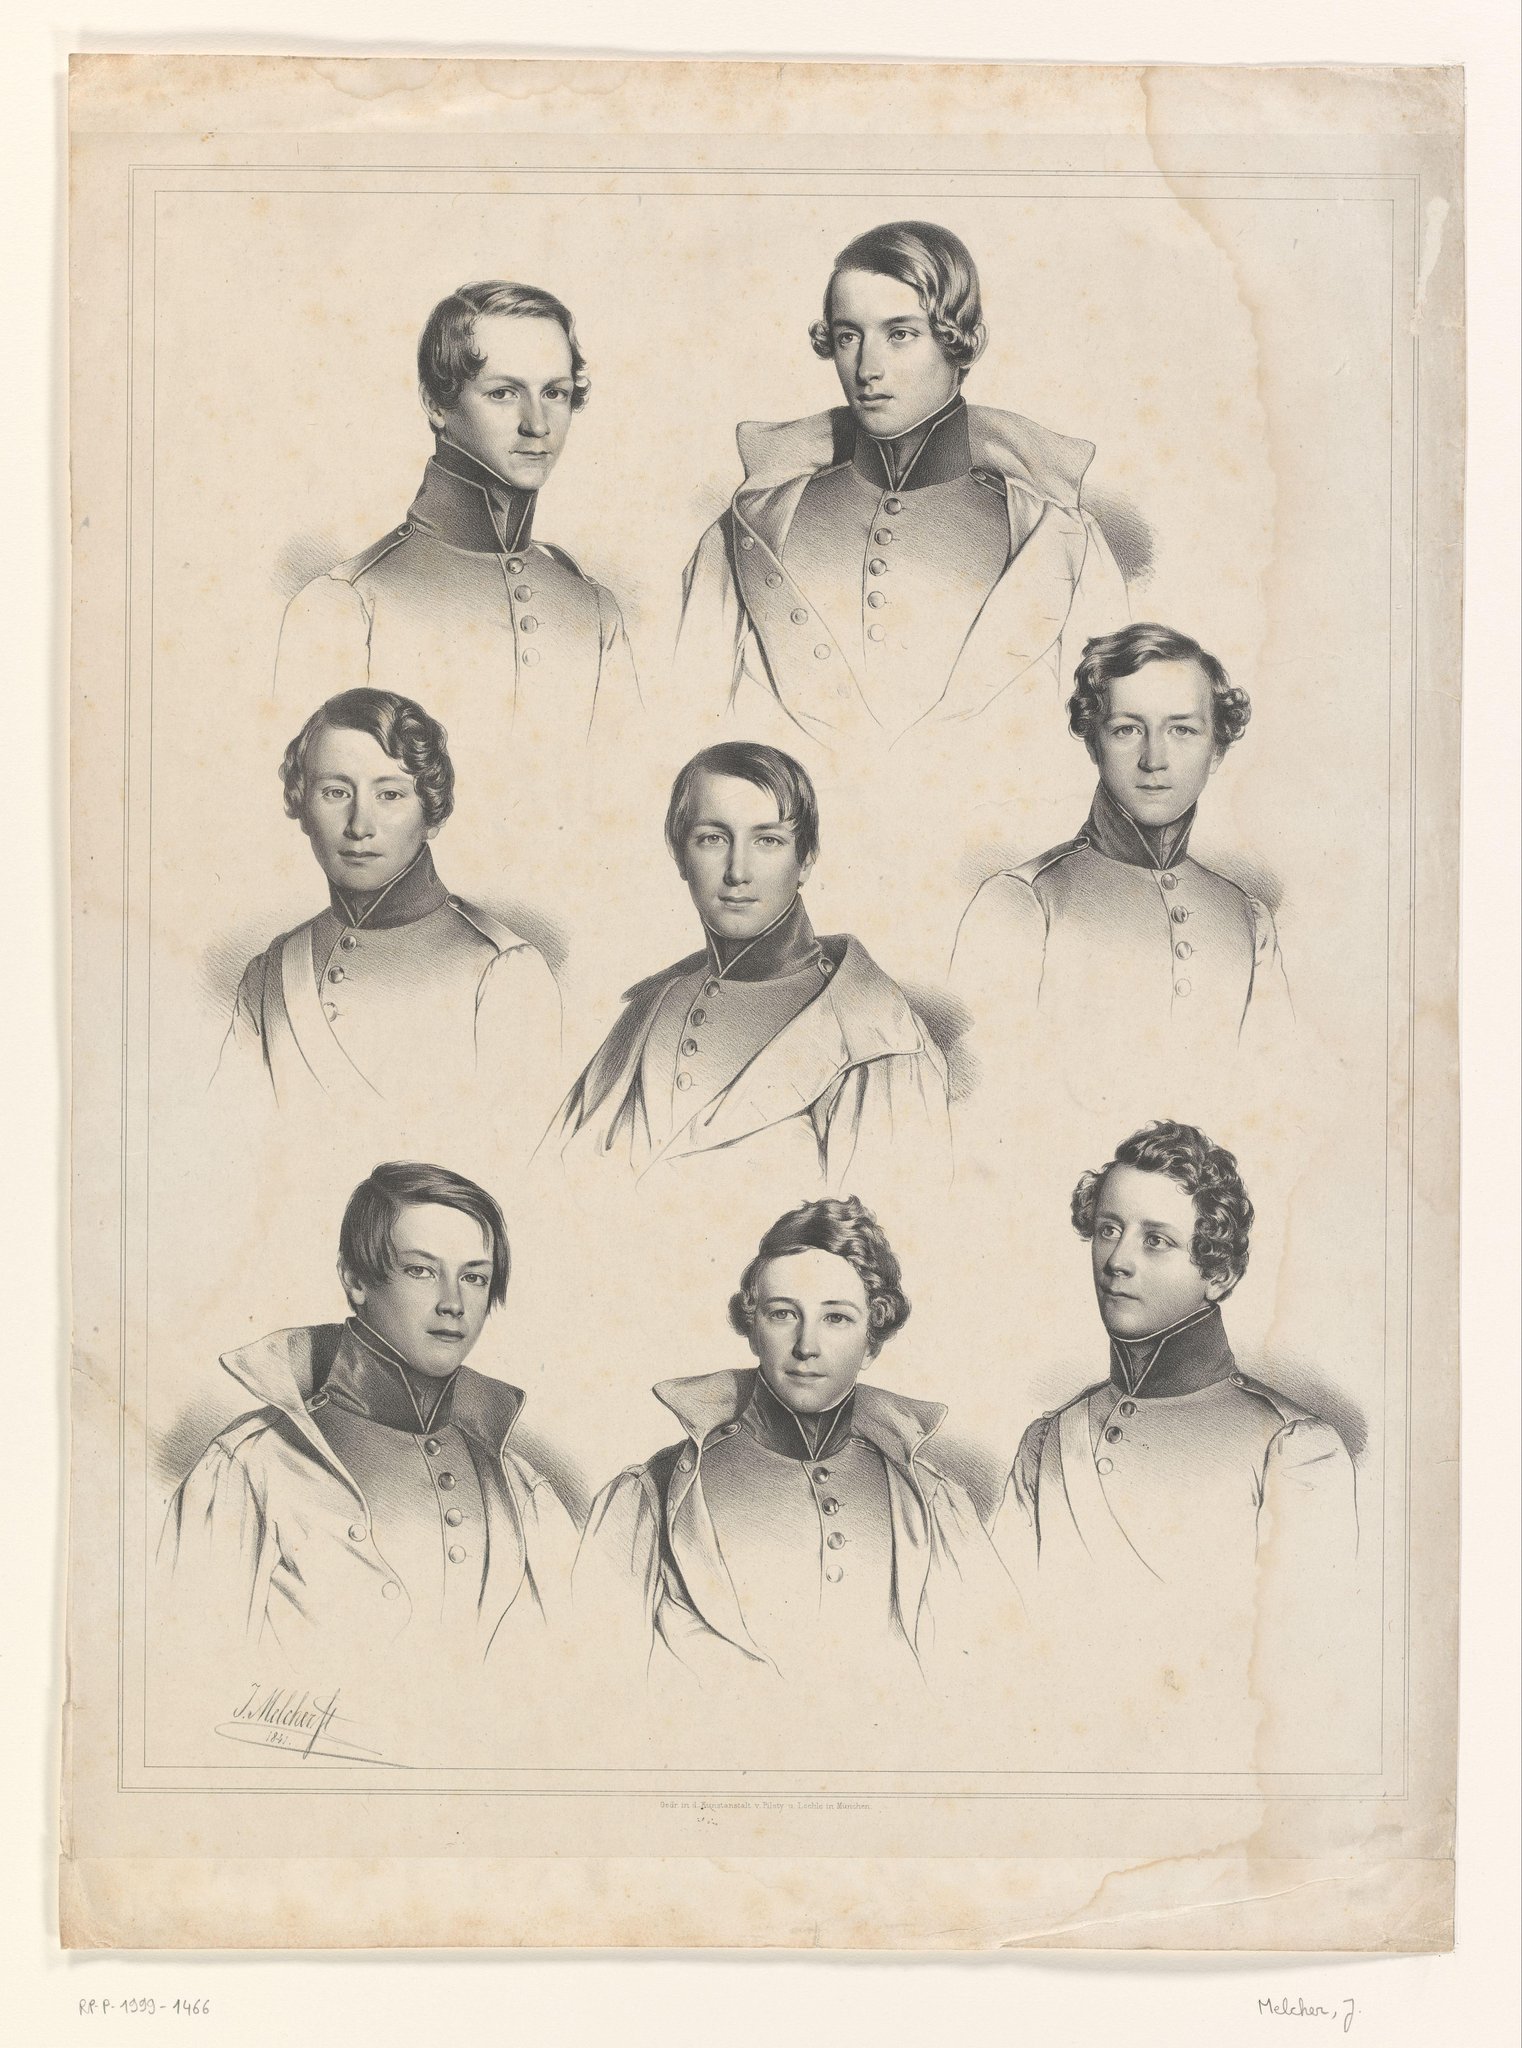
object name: print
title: Portretten van acht onbekende jongemannen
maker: jakob melcher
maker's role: print maker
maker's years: 1816-1882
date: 1841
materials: paper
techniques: lithograph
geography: munich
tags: historical persons, youth, adolescent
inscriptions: mark: Lugt 4100